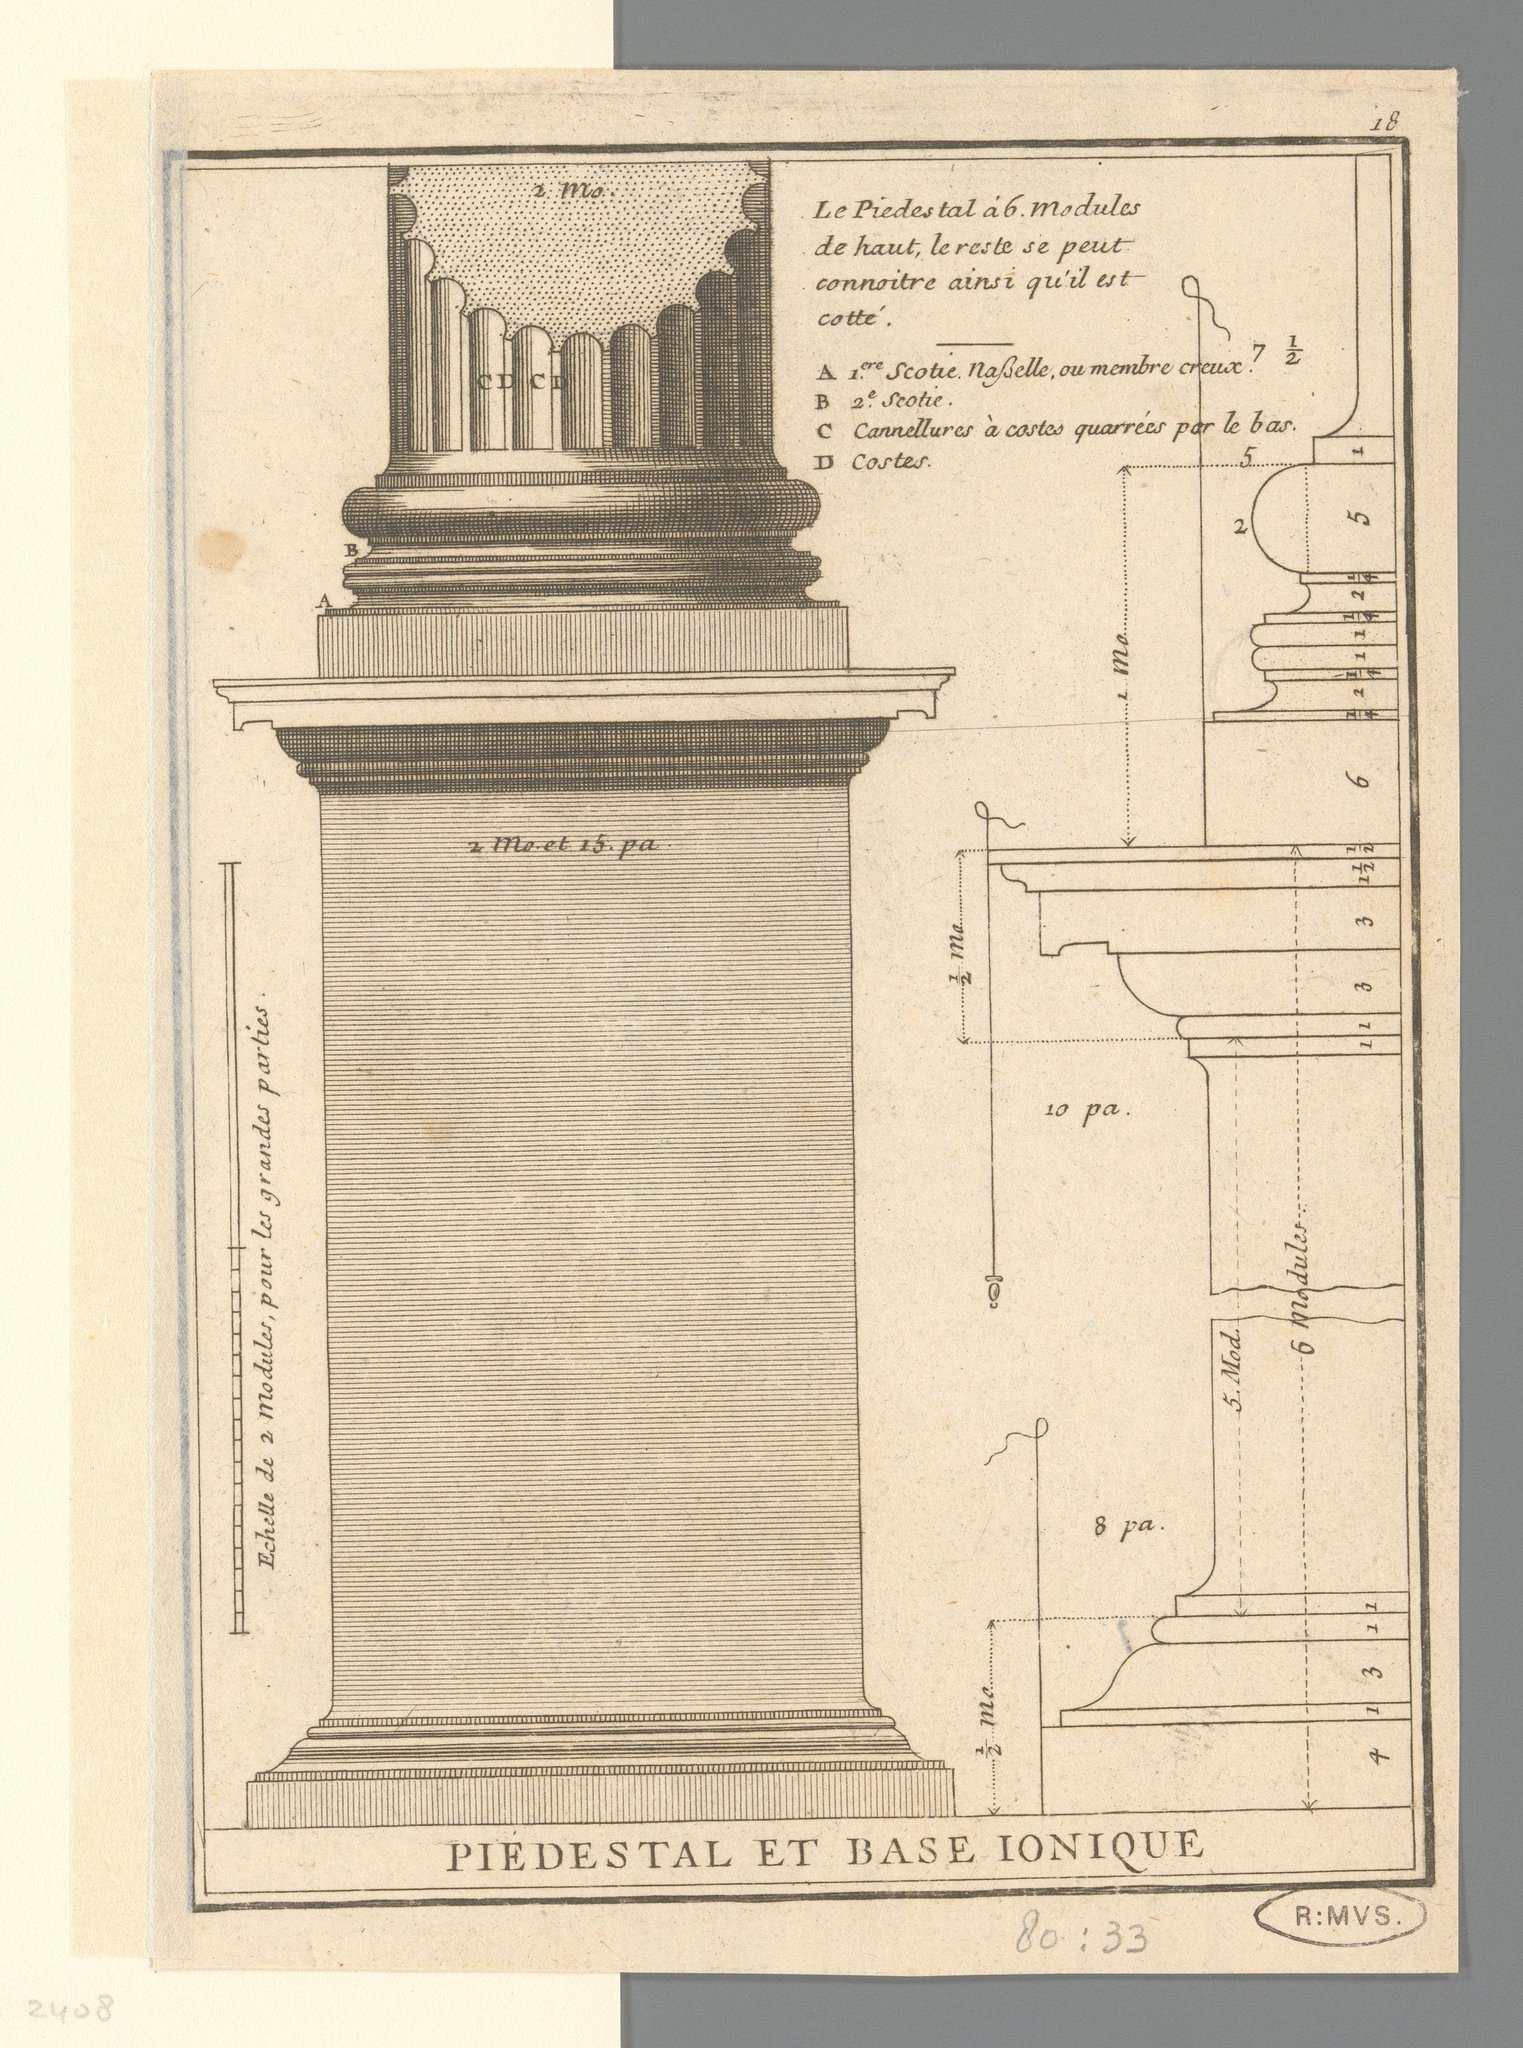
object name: print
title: Le Nouveau Vignole ou Regles Des Cinq Ordres D'Architecture (...)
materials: paper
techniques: etching, letterpress printing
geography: paris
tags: doric order ~ architecture, base (~ column, pillar)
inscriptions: collector's mark: Lugt 2228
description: Pagina 18 uit: Babel, Pierre Edme. Le Nouveau Vignole ou Regles Des Cinq Ordres D'Architecture (...). Parijs: Chereau, François (II), 1755.